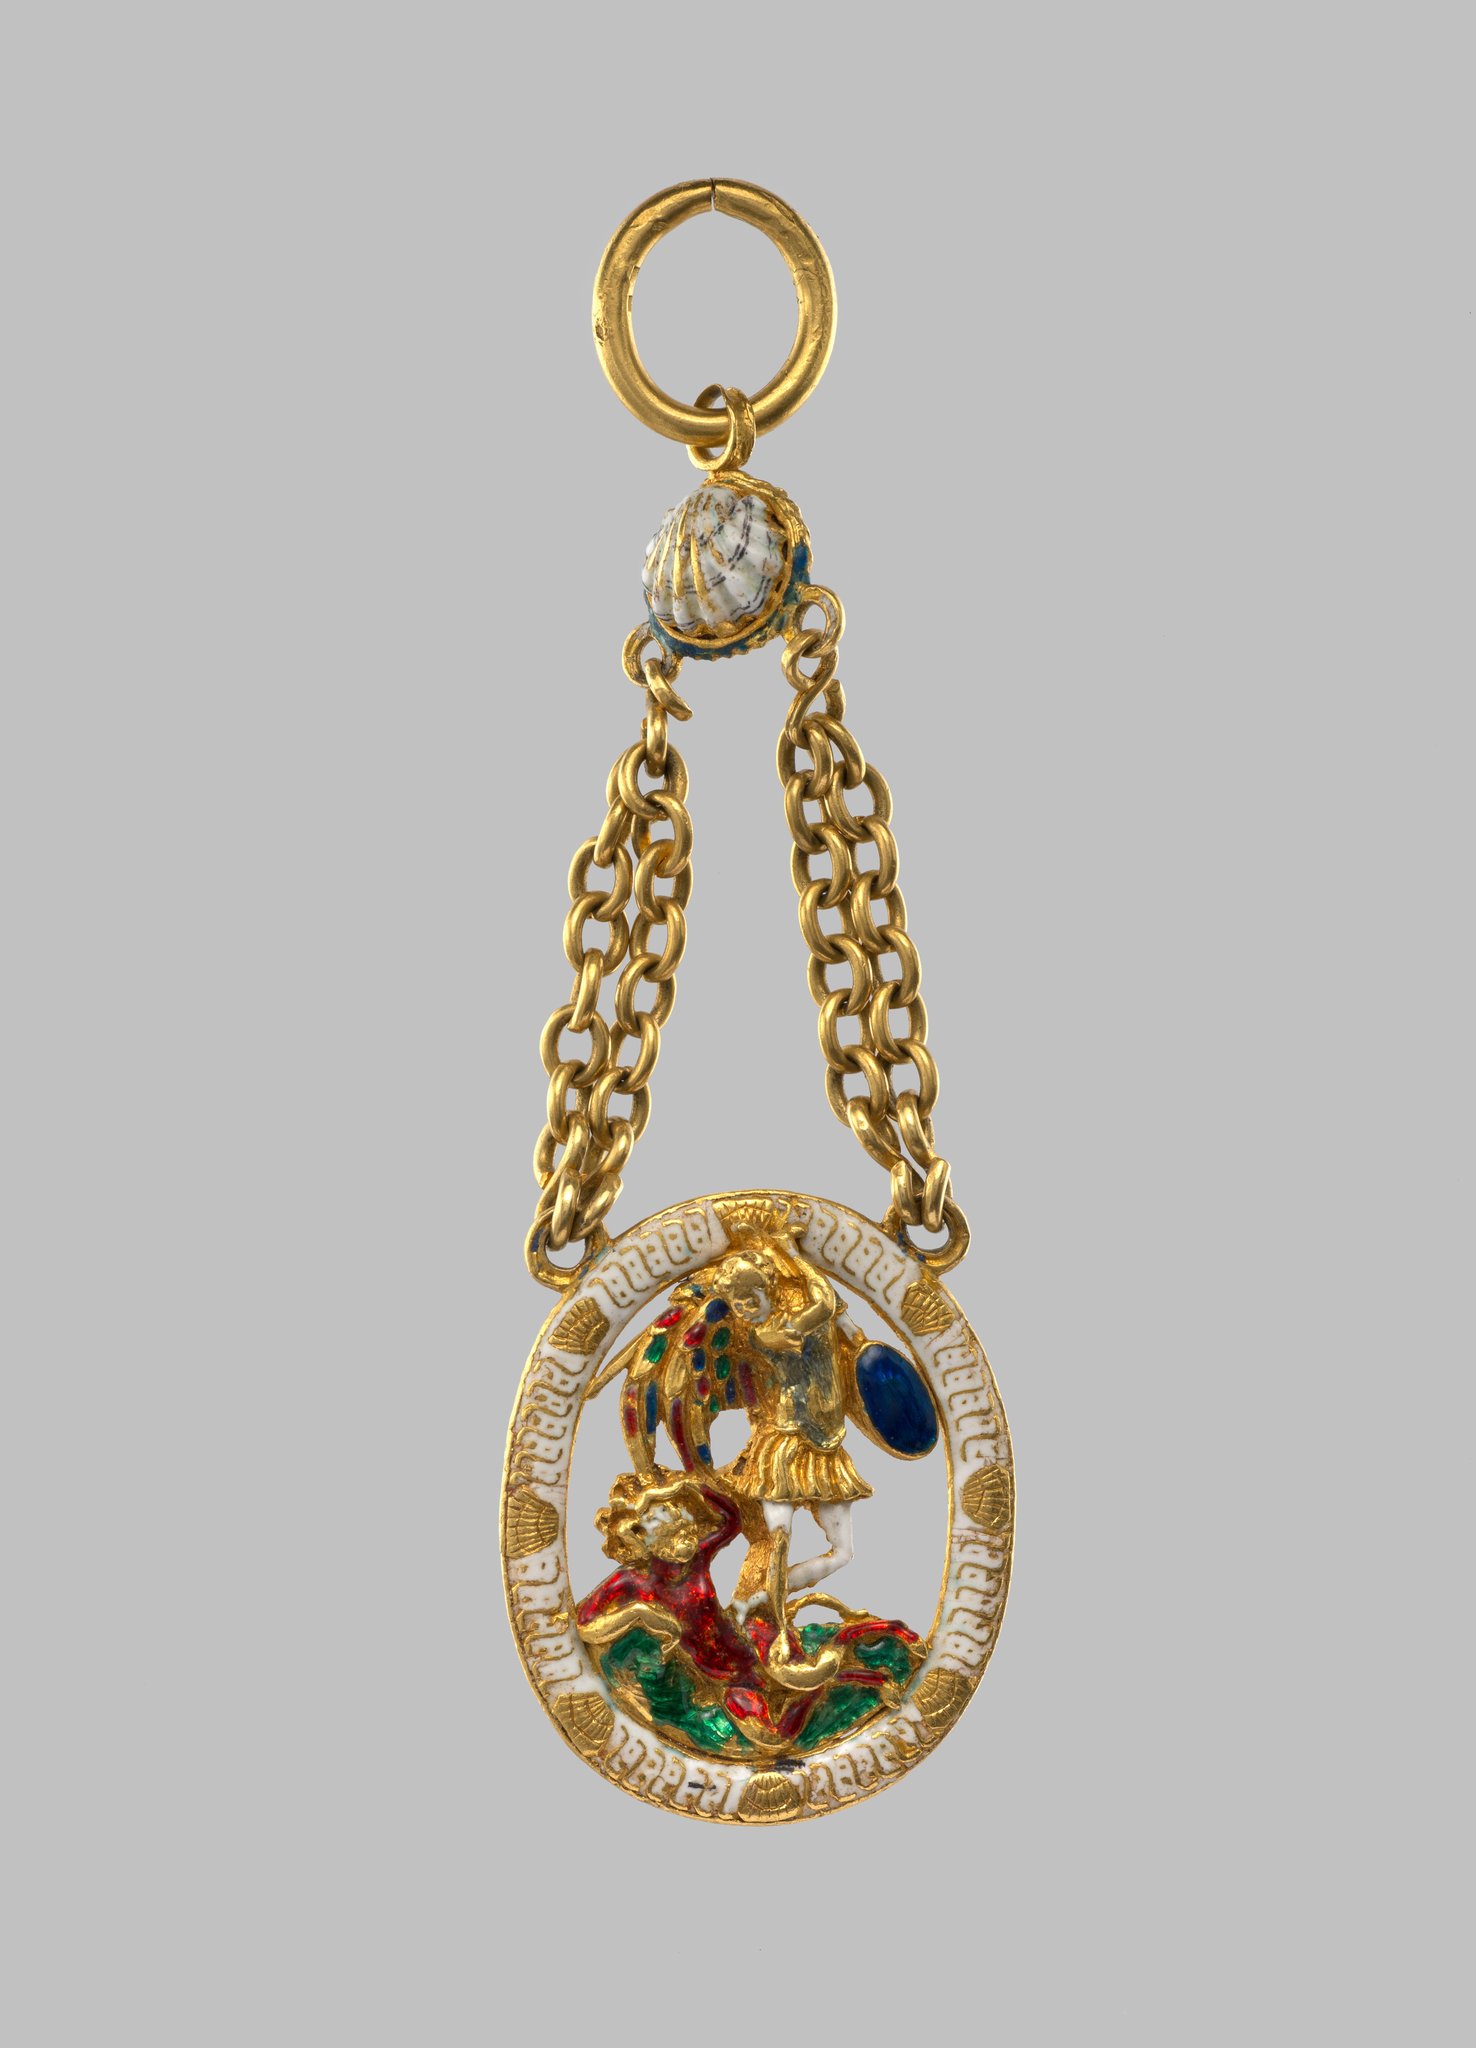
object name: badge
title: Badge of the Order of Saint Michael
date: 1601-1700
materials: enamel, gold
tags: saint michael